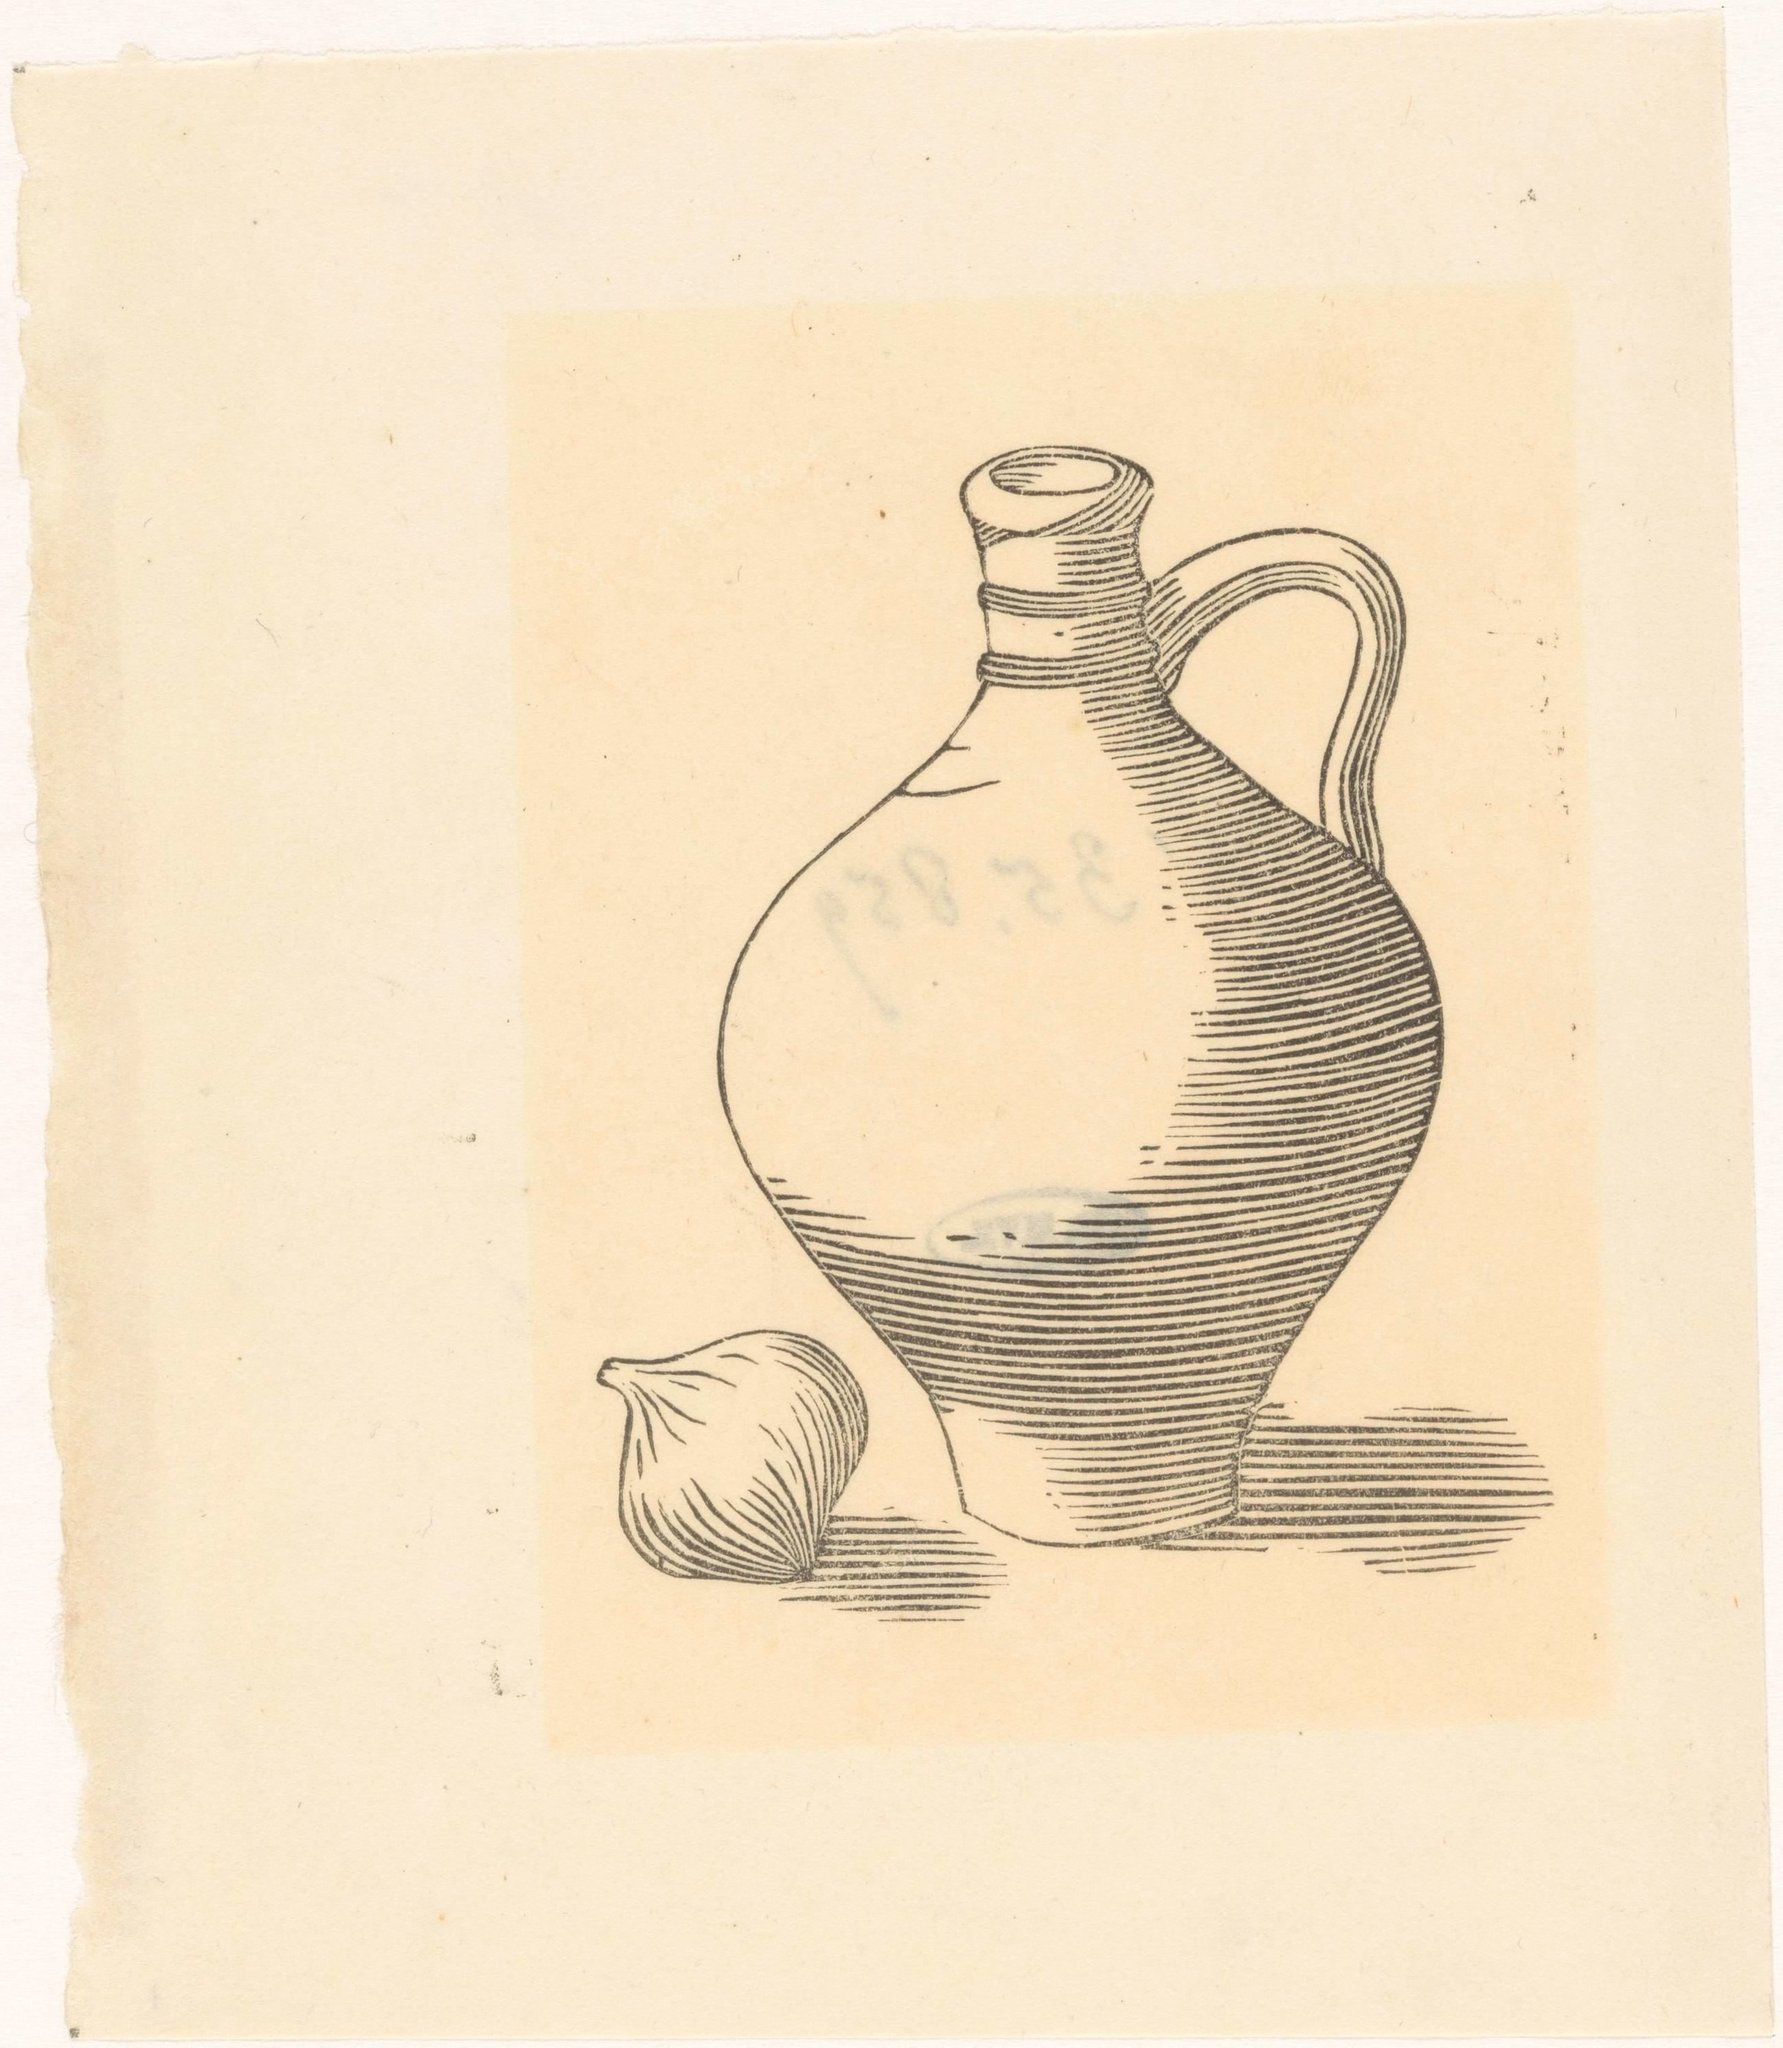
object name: print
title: Stilleven met kruik en ui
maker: julie de graag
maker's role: draughtsman, print maker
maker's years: 1877-1924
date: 1900-1903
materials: paper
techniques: woodcut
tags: (non-fruit) products of plants or trees: onion, container of ceramics: jar, jug, pot, vase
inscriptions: collector's mark: Lugt 2228